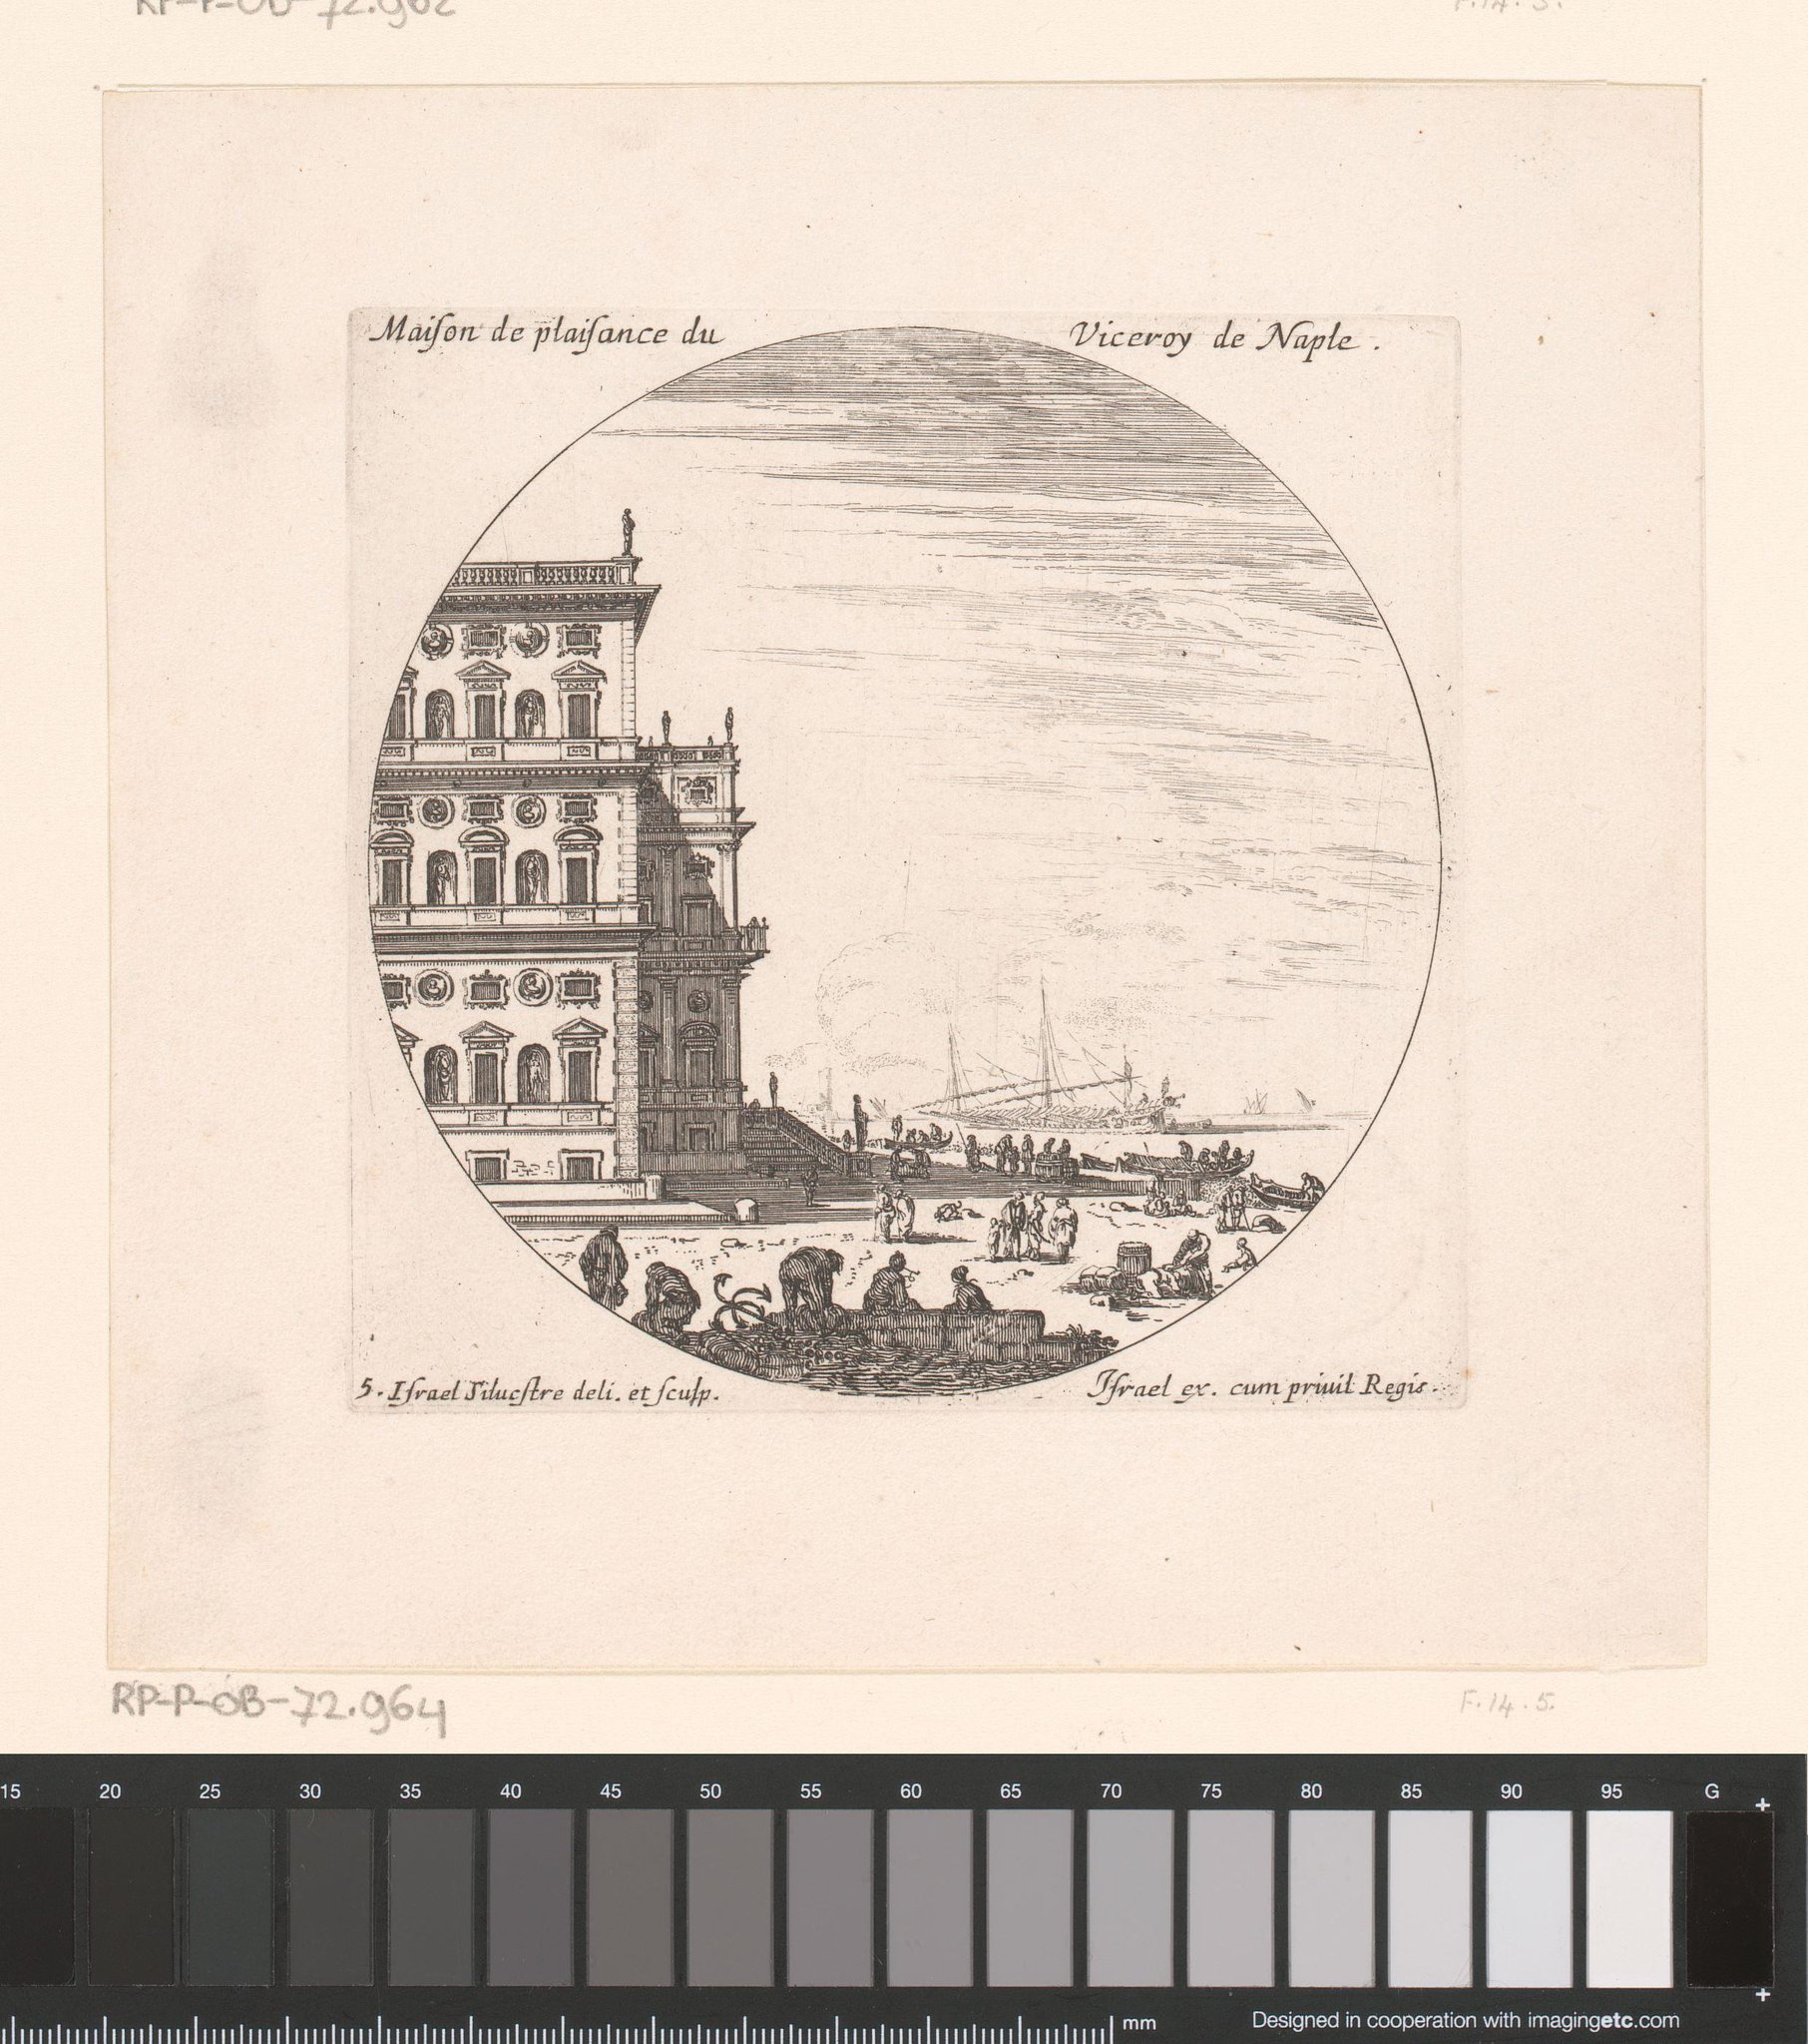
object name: print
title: Diverse Vedute di Porti di Mare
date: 1647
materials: paper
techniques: etching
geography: france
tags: harbour, city-view in general; 'veduta', naples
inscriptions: collector's mark: Lugt 240